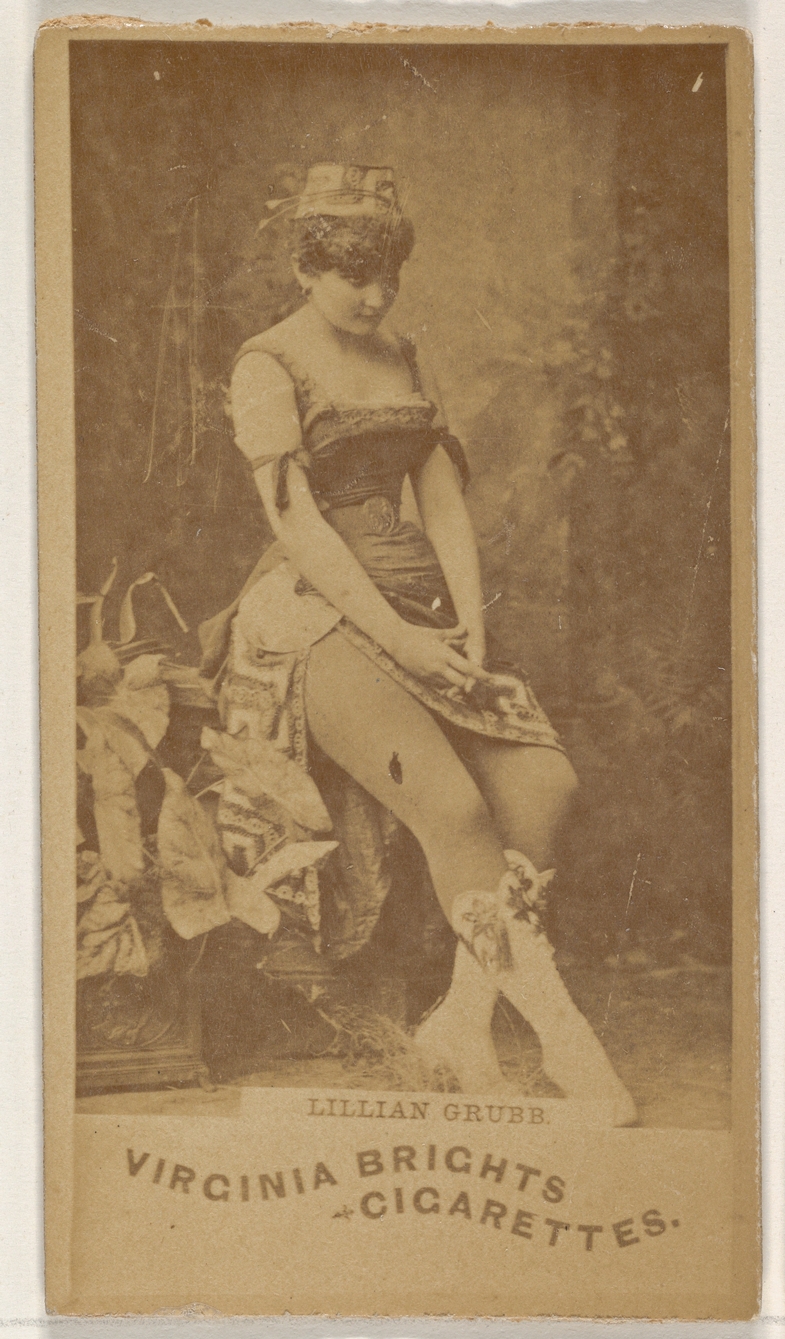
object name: photograph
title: Lillian Grubb, from the Actors and Actresses series (N45, Type 1) for Virginia Brights Cigarettes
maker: allen & ginter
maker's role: publisher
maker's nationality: american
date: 1888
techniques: albumen silver print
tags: portraits,women,actresses